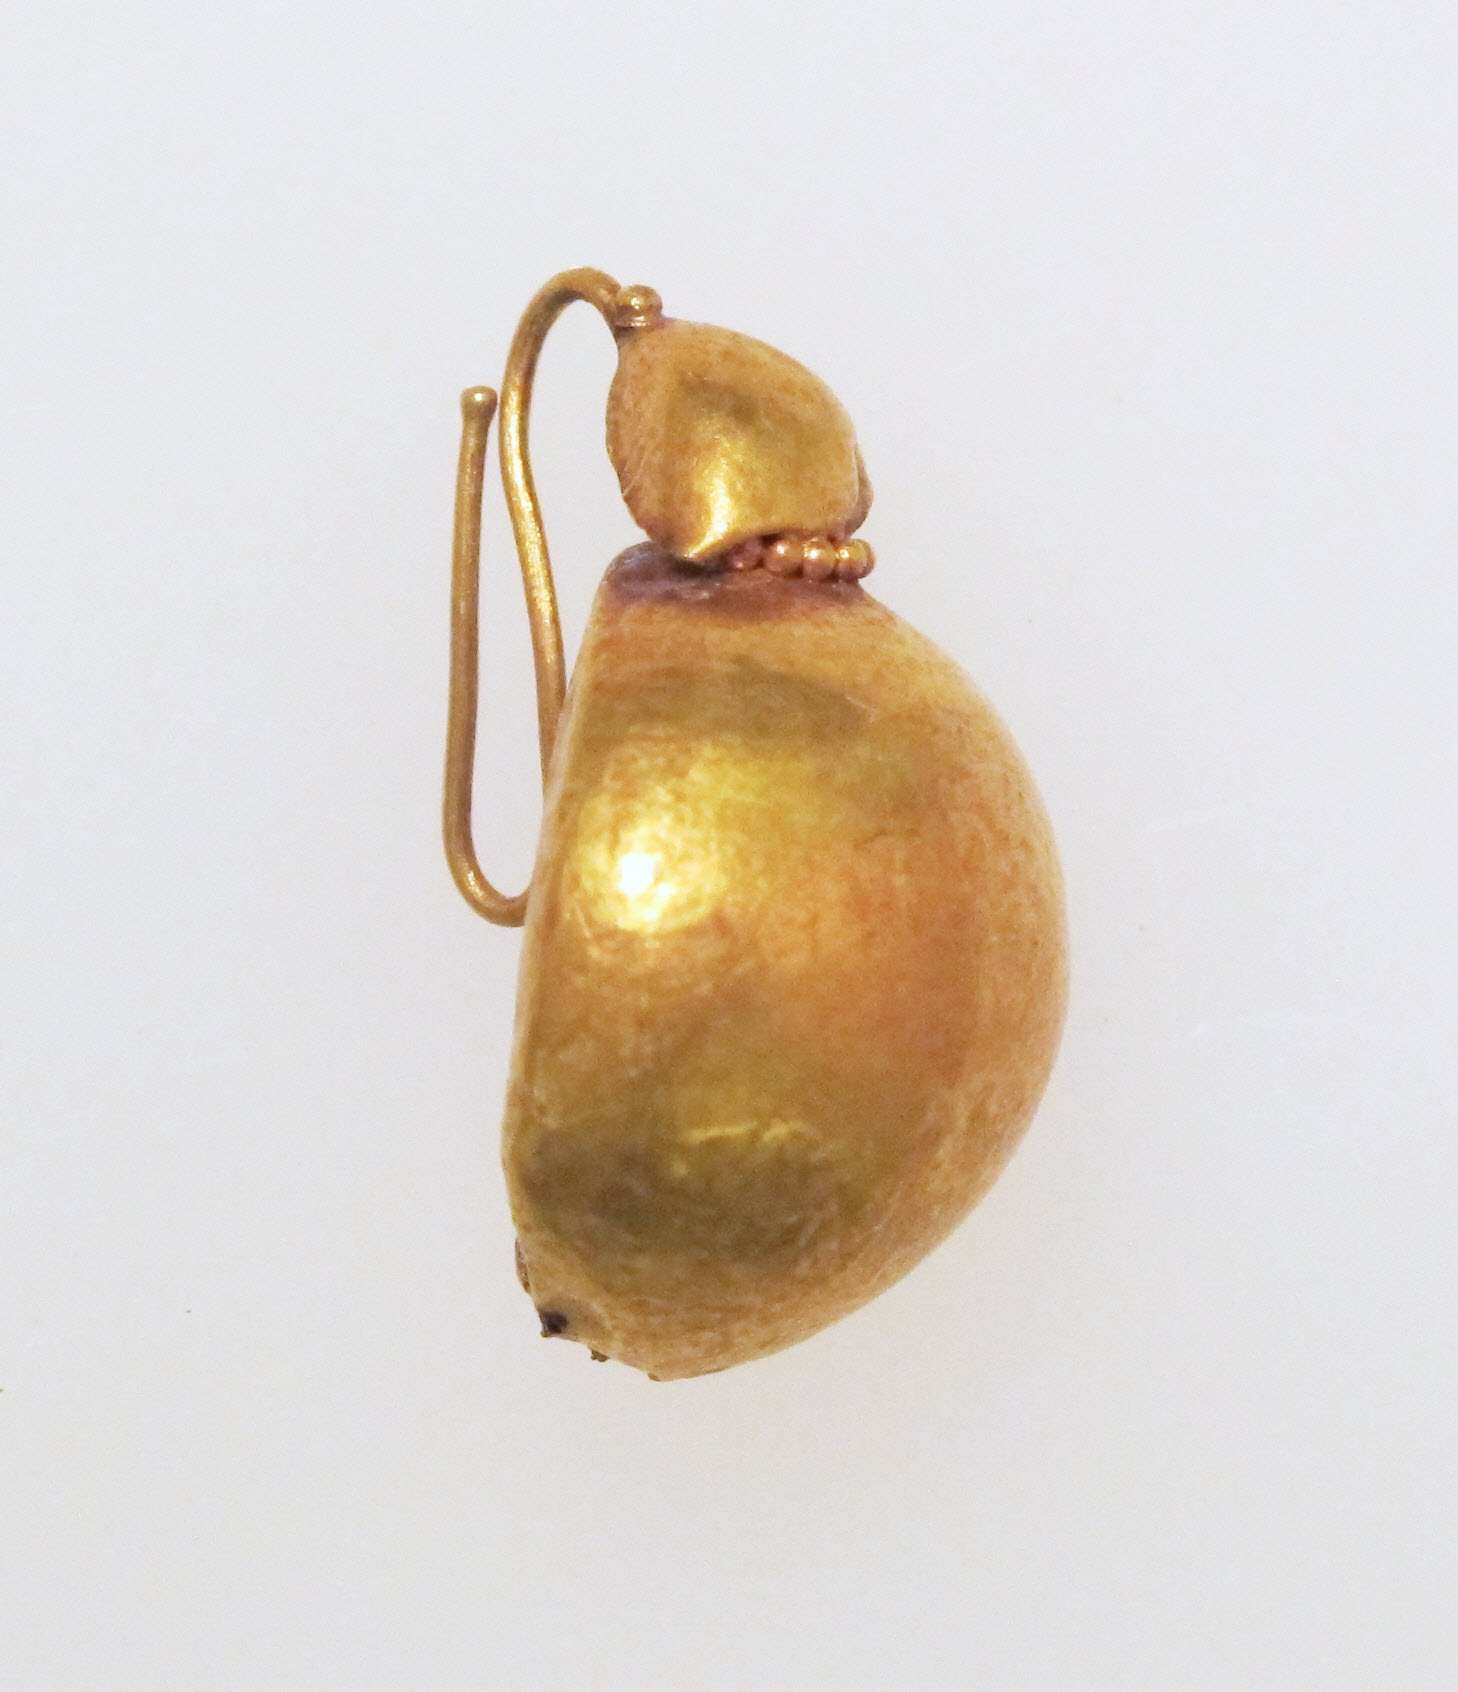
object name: earring hook type with sphere end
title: Earring-hook type with sphere ends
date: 7000 BCE-330 CE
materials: gold